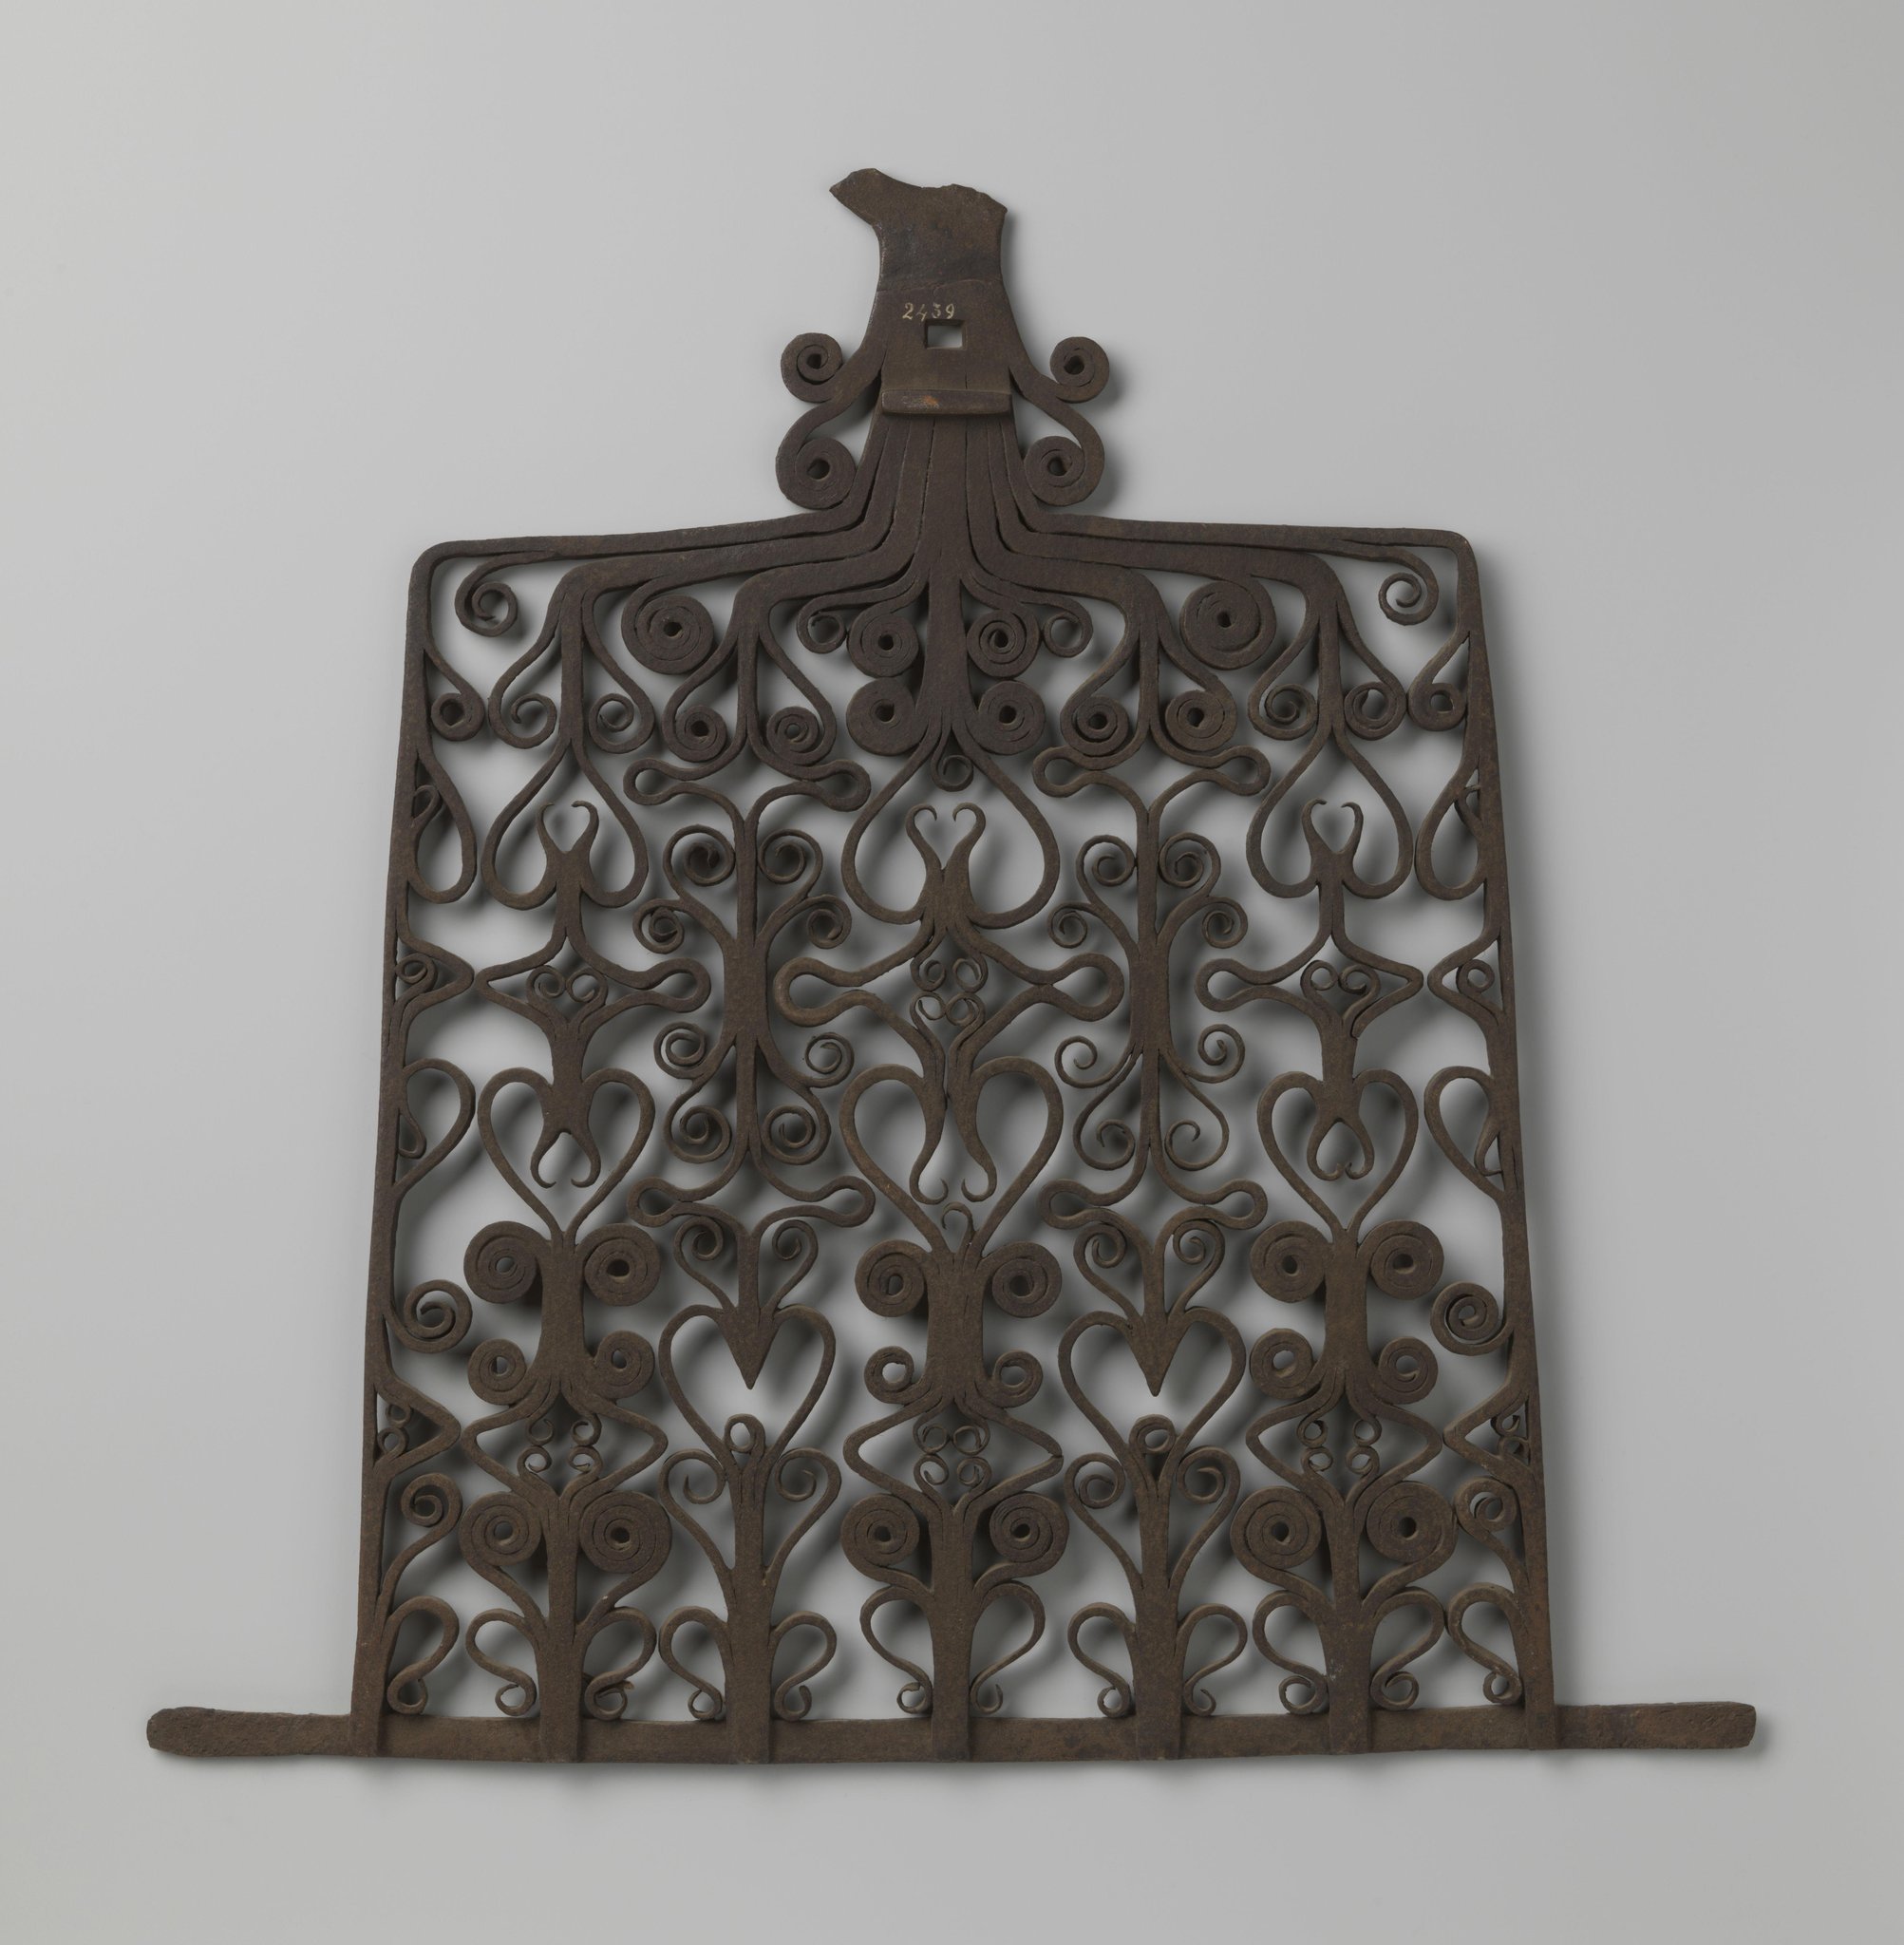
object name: rooster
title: Rooster van ijzer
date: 1400-1950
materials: iron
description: Een ijzeren geslagen rooster. Een gedeelte van de steel ontbreekt.